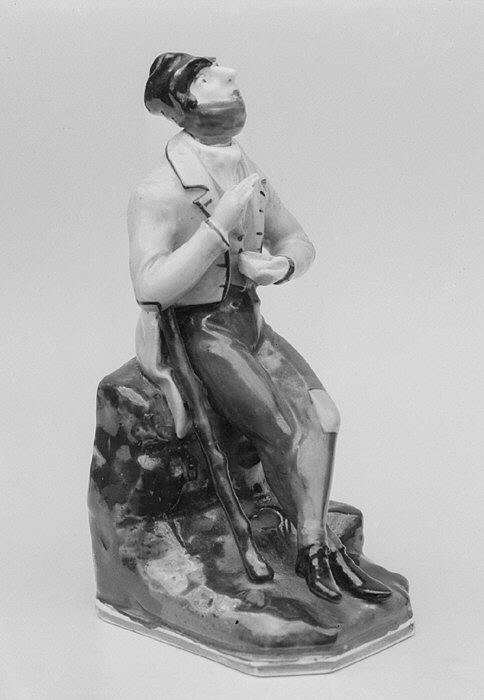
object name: bottle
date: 1834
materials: hard paste porcelain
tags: men